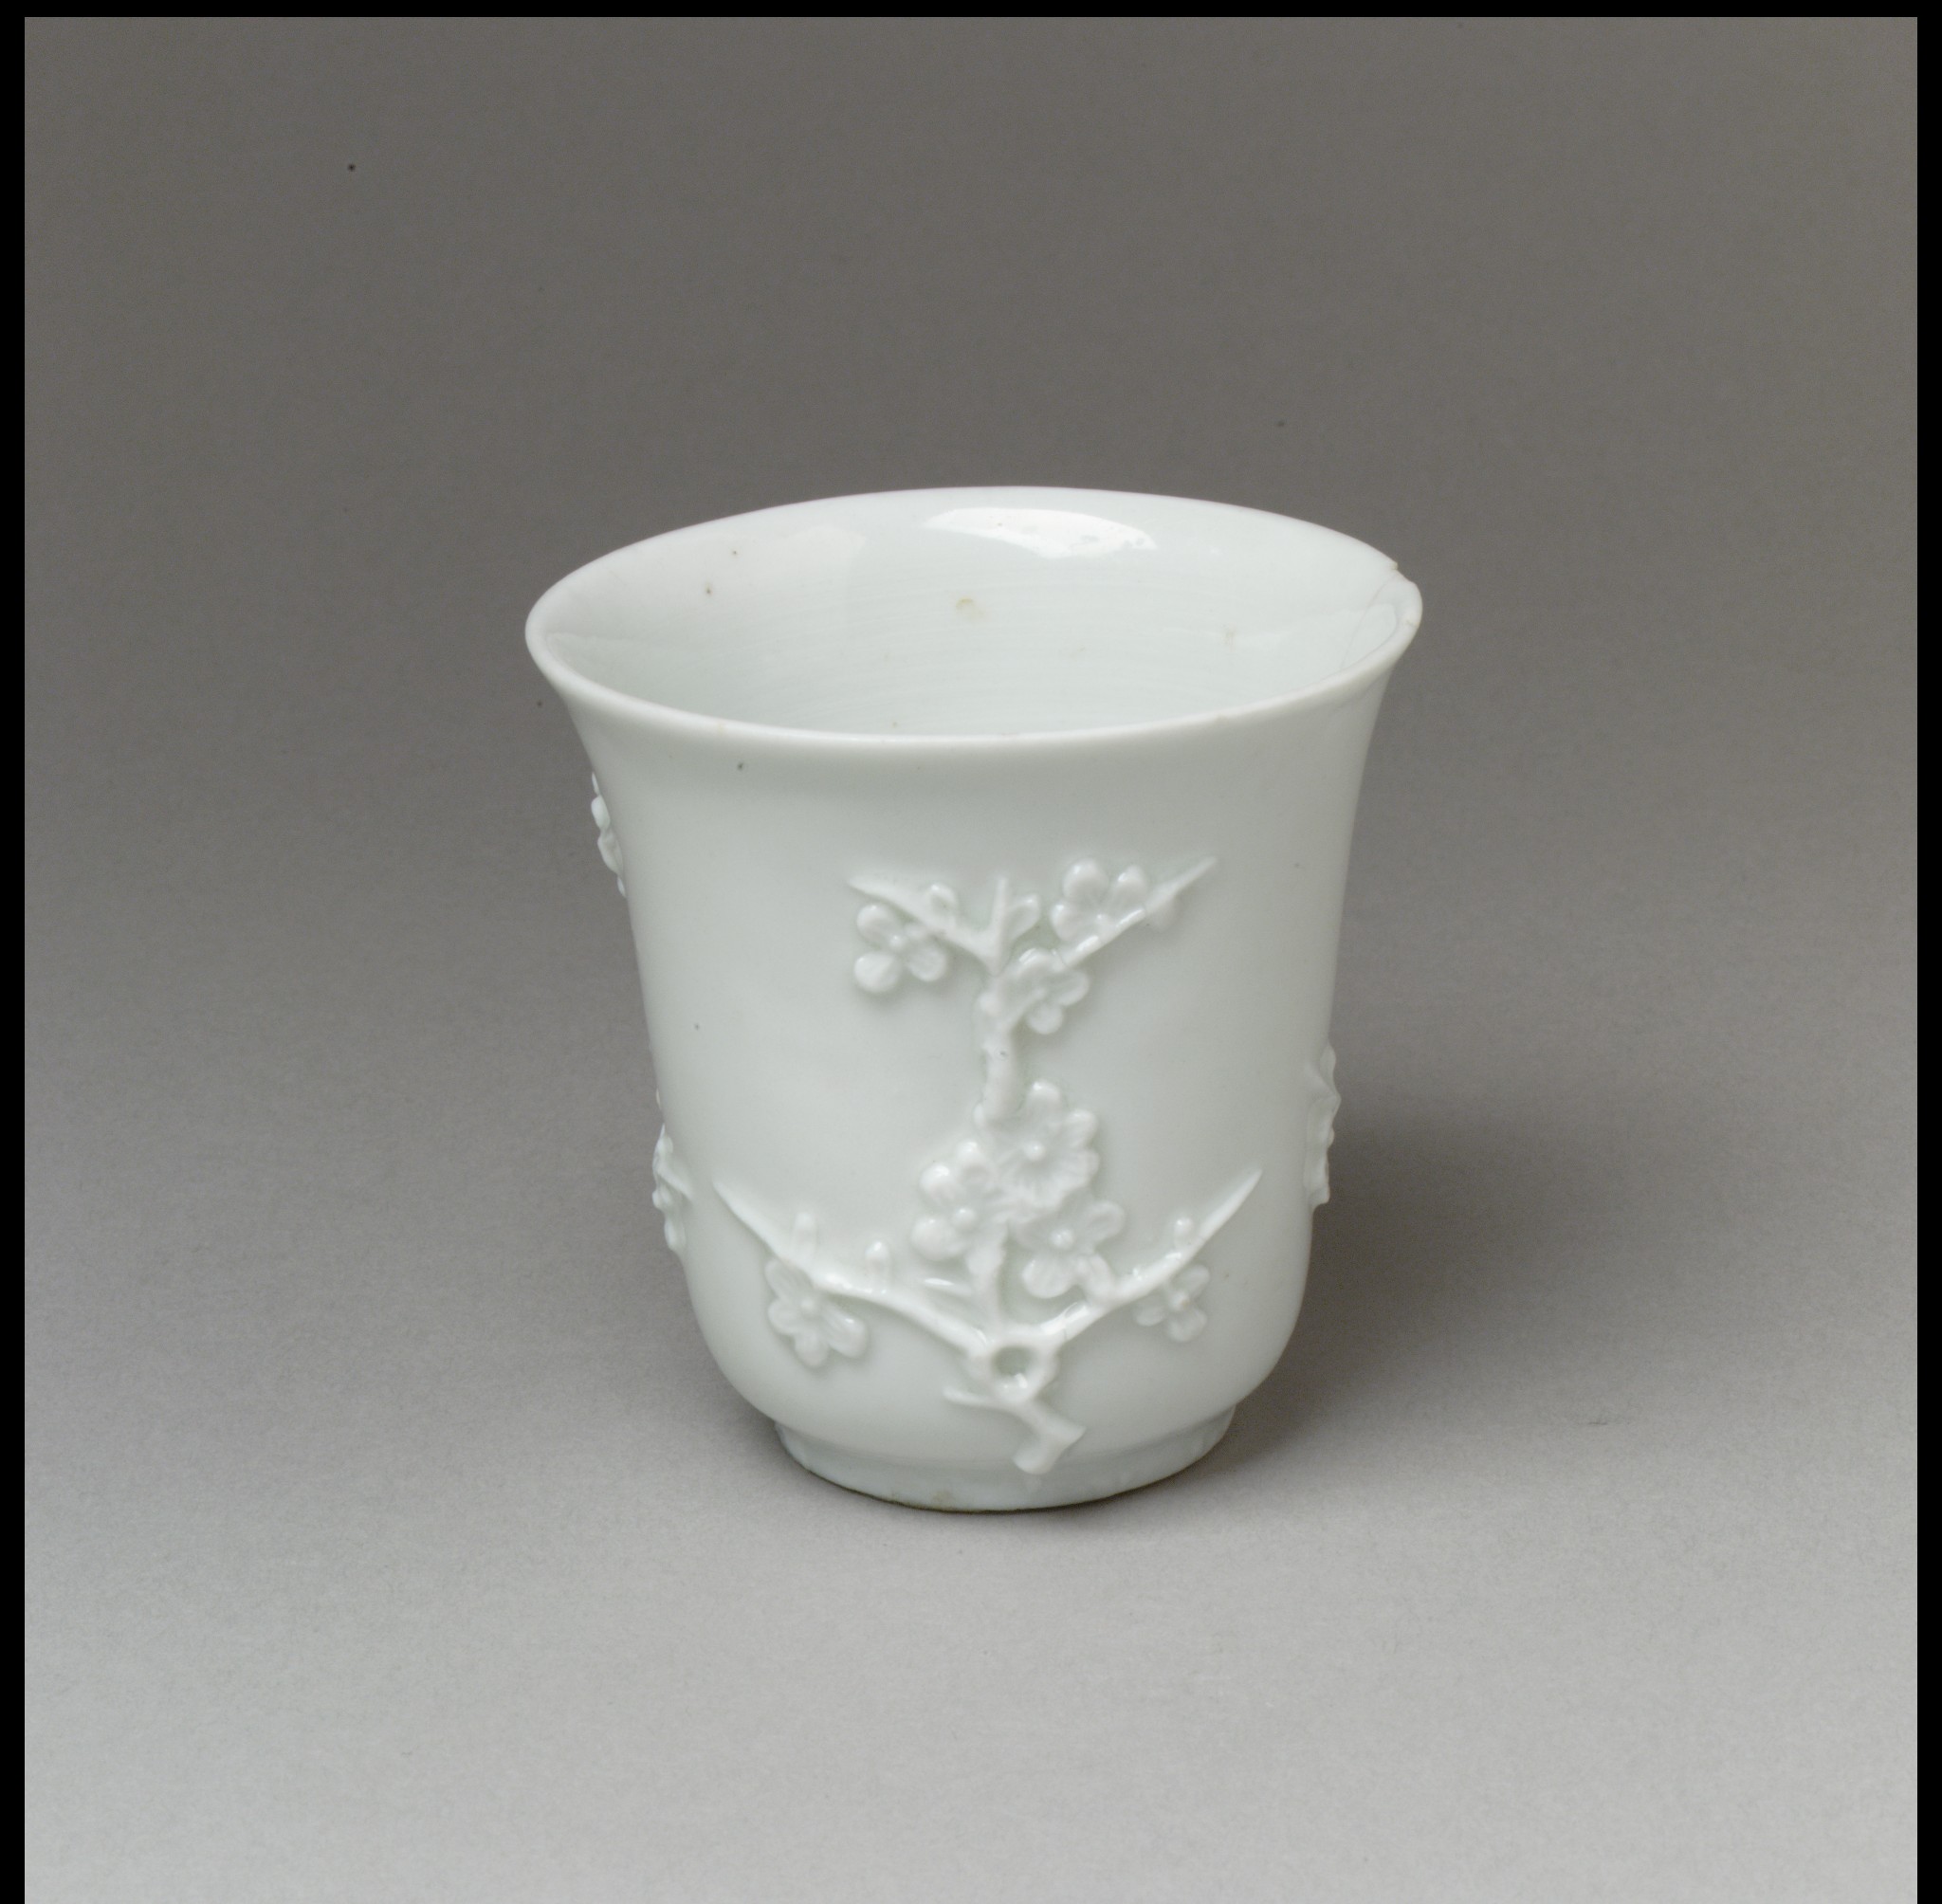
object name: beaker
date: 1767-1800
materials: hard paste porcelain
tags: flowers